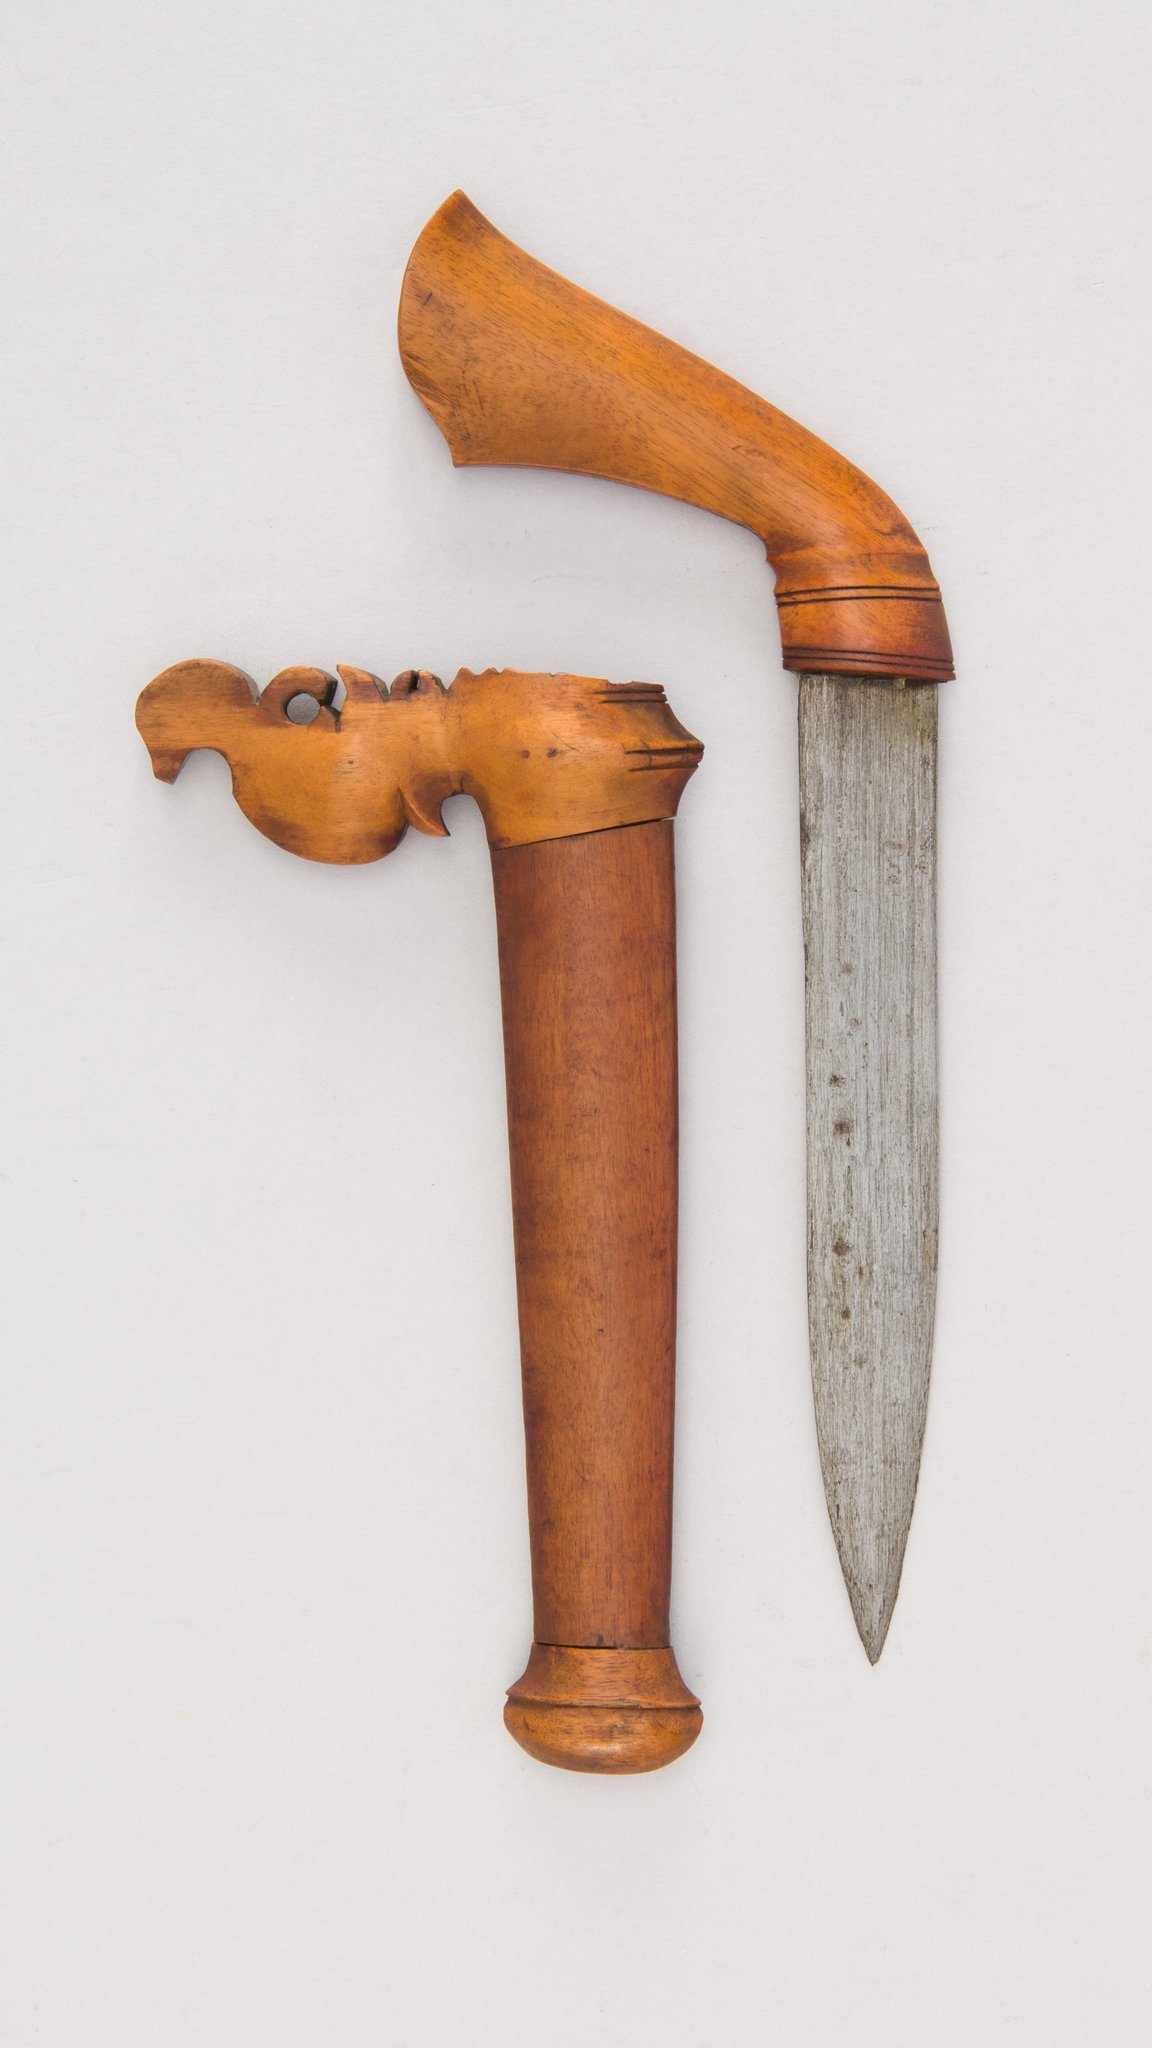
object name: knife with sheath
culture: indonesian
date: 1701-1900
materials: steel, wood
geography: indonesia